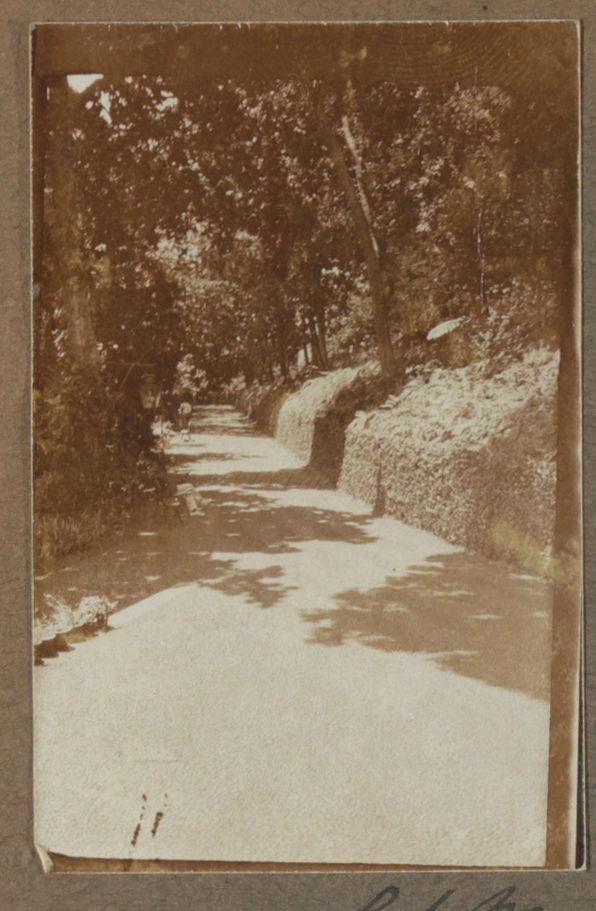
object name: photograph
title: De weg naar het Mount Palace Hôtel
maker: Anonymous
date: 1908-1922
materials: photographic support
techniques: daylight paper print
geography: madeira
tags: forest path or lane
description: Onderdeel van fotoalbum van een onbekende Nederlandse familie met opnames van Suriname, Europa en Nederlands-Indië.